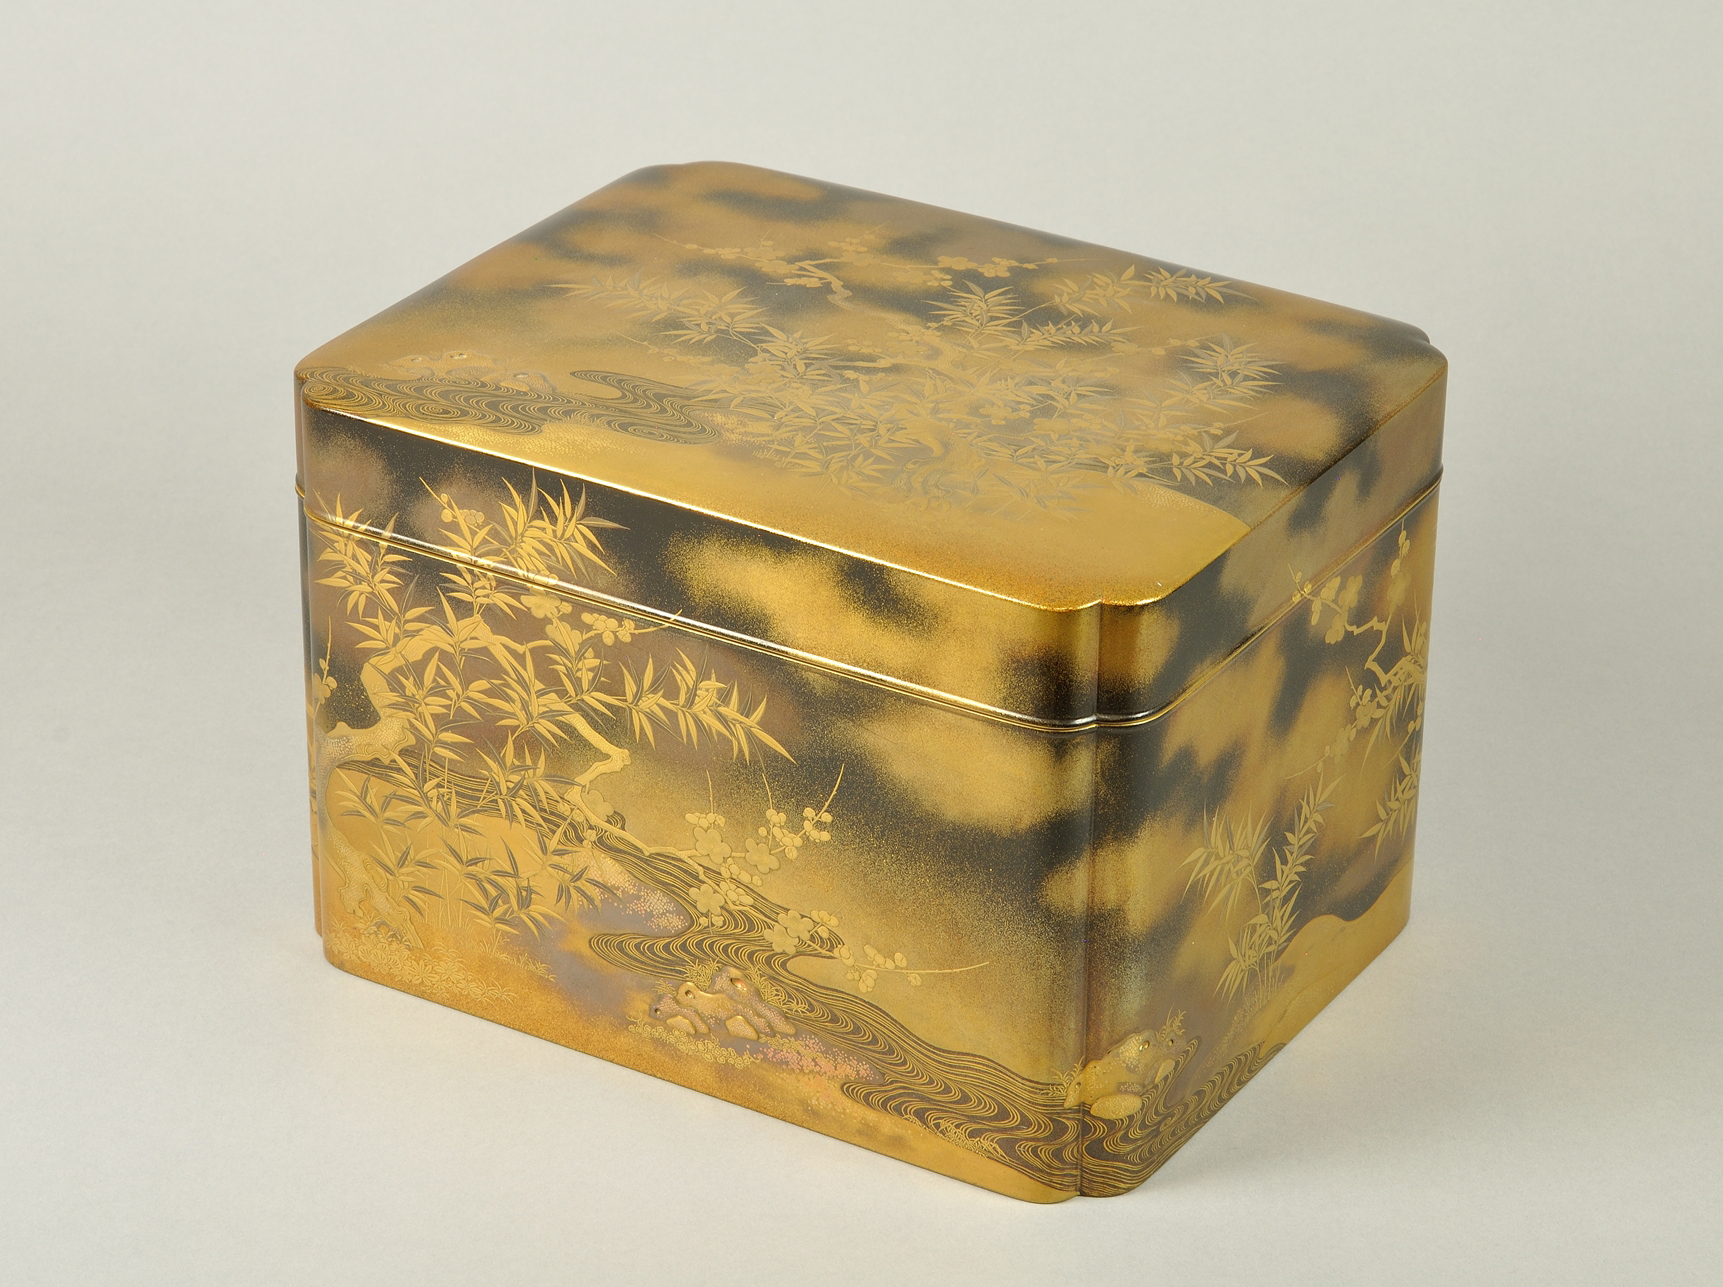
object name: incense box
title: Box for Incense Set with Design of Plum and Bamboo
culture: japanese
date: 1801-1900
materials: gold, lacquer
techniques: maki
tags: flowers,trees